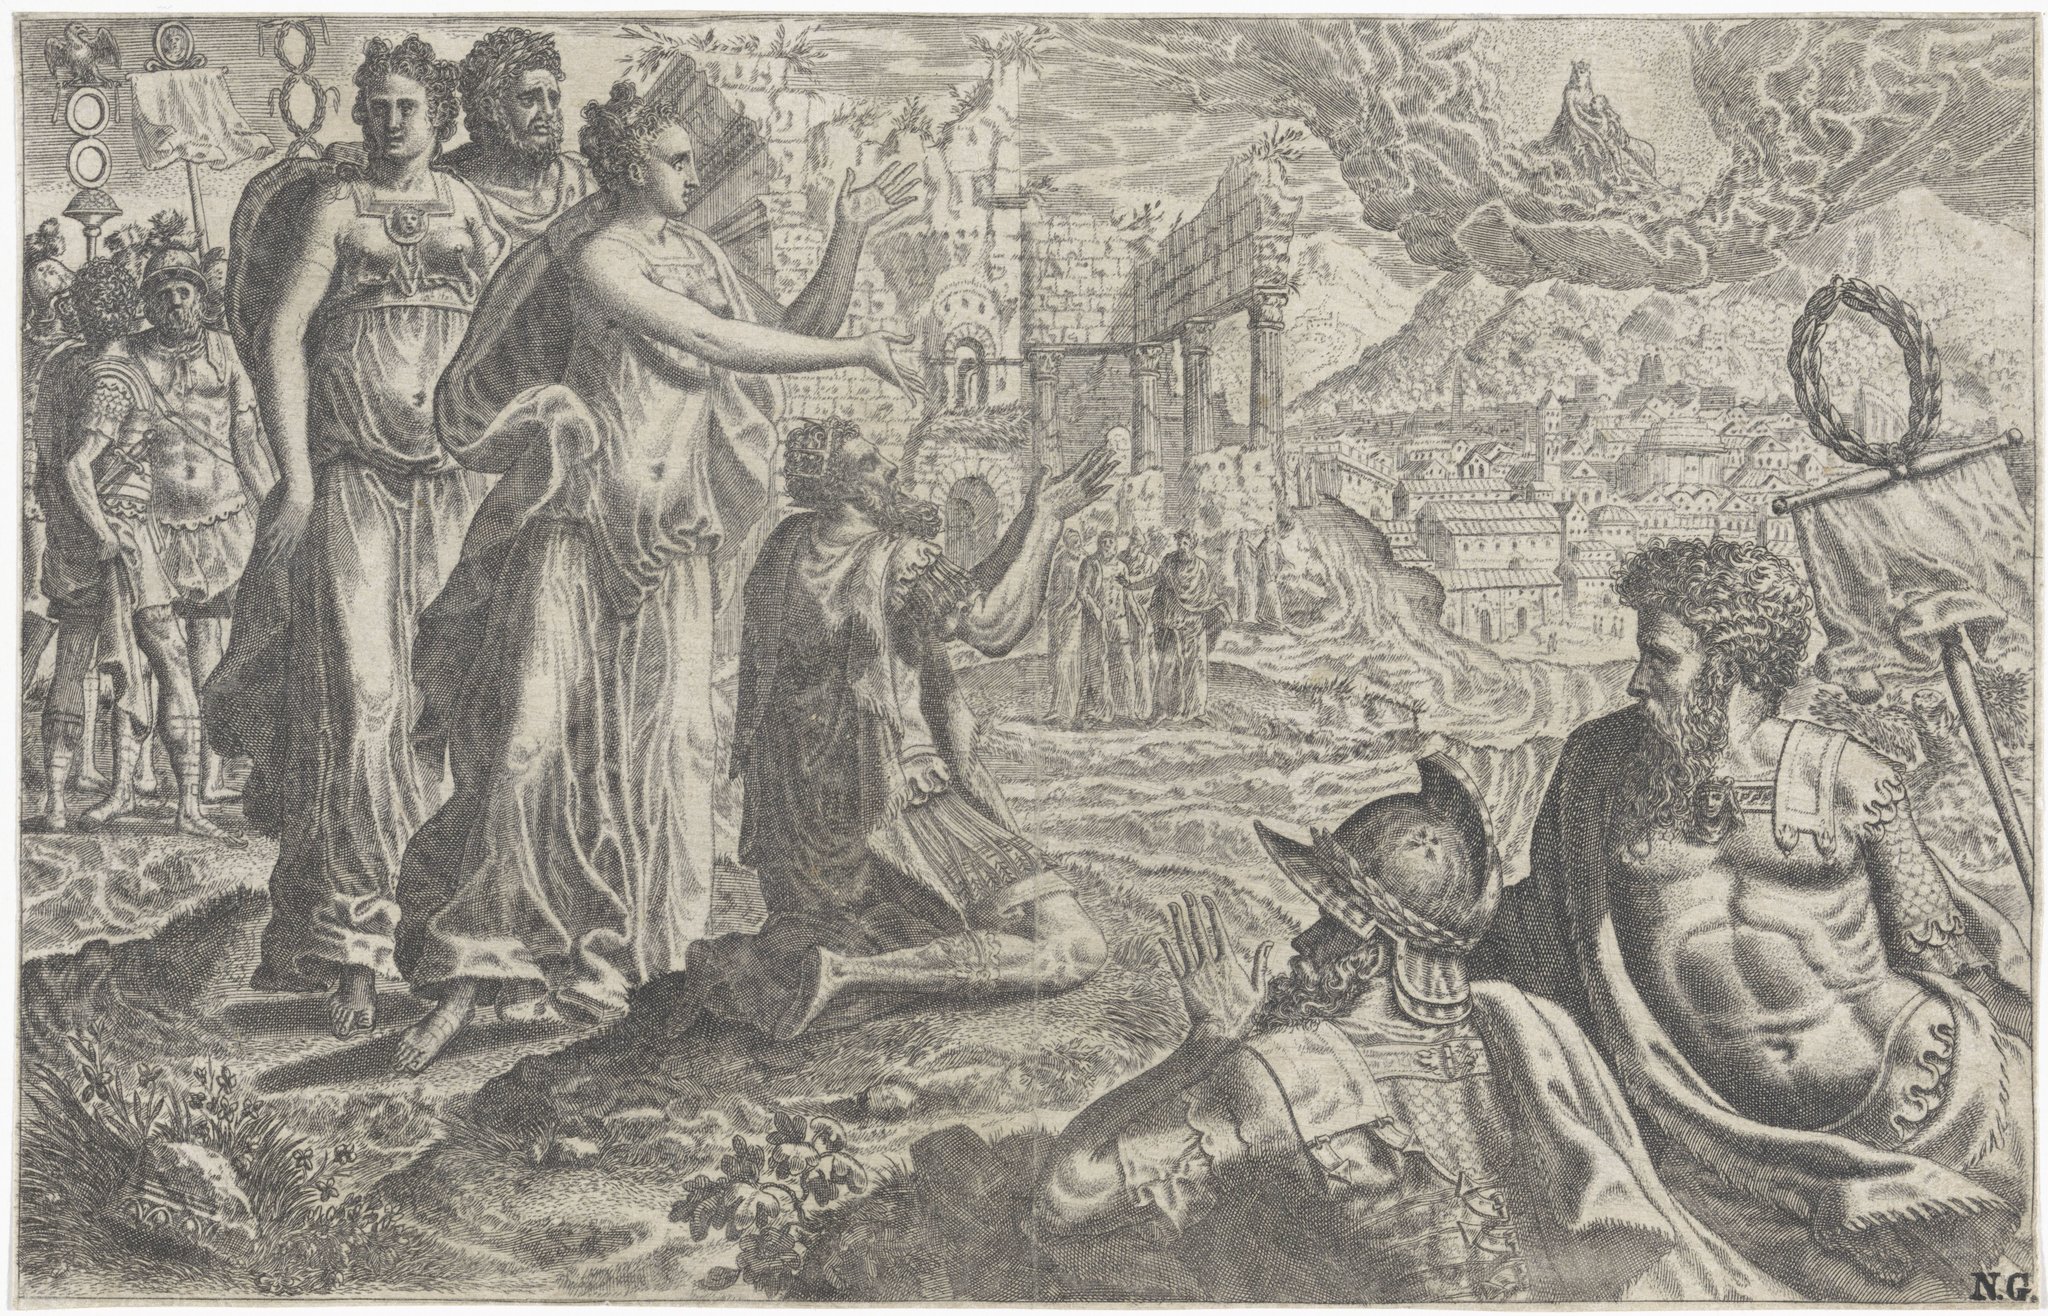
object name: print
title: Keizer Augustus en de Tiburtijnse Sibille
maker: lambertus suavius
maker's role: print maker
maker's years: 1514-1564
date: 1520-1567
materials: paper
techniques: engraving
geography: southern netherlands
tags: the tiburtine sibyl and augustus: the sibyl reveals to the emperor a vision of the madonna in heaven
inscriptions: collector's mark: Lugt 1967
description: De Tiburtijnse Sibille voorspelt aan keizer Augustus dat er een kind zal worden geboren, dat groter zal zijn dan alle Romeinse goden. Daarop ziet Augustus een visioen. Aan de hemel verschijnt Maria met het Christuiskind. Keizer Augustus knielt.